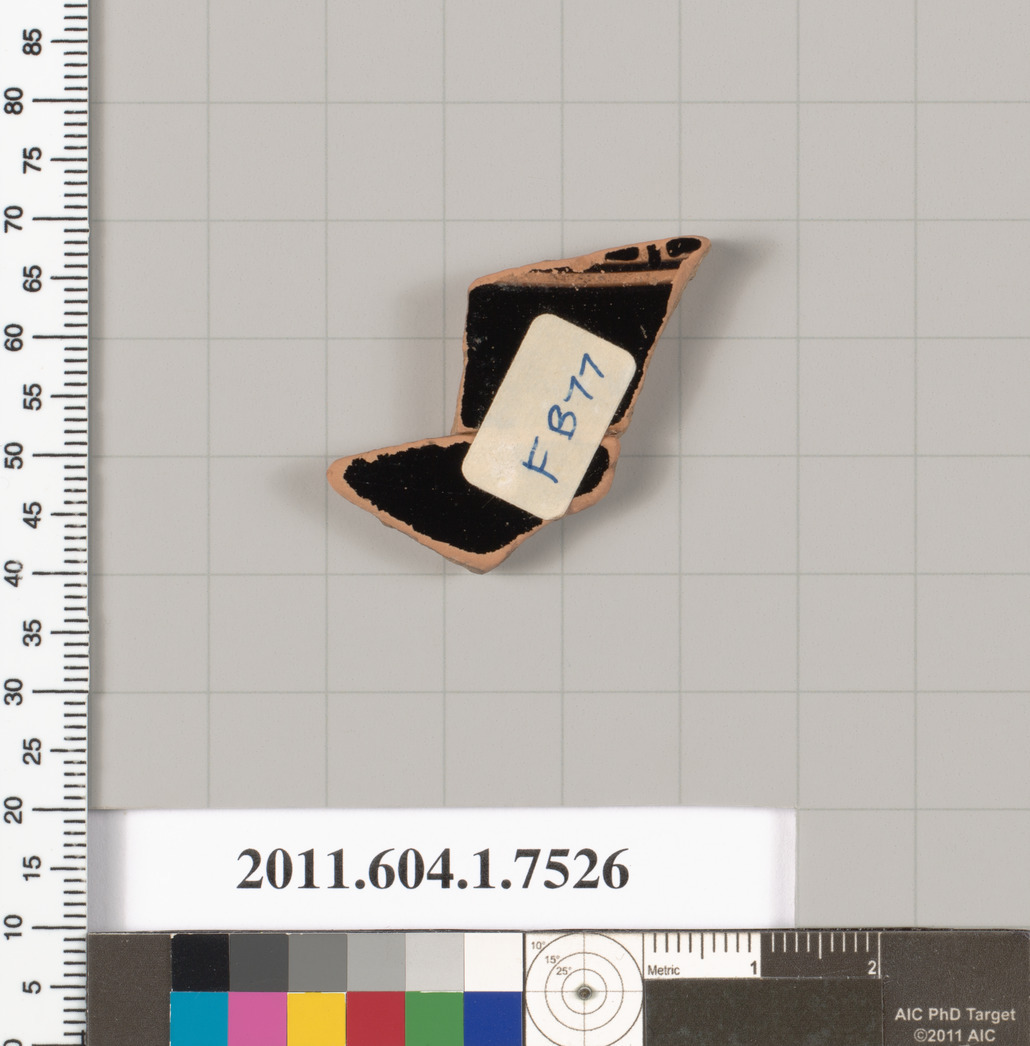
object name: kylix fragment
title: Terracotta fragment of a kylix (drinking cup)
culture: greek, attic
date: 460-450 BCE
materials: terracotta